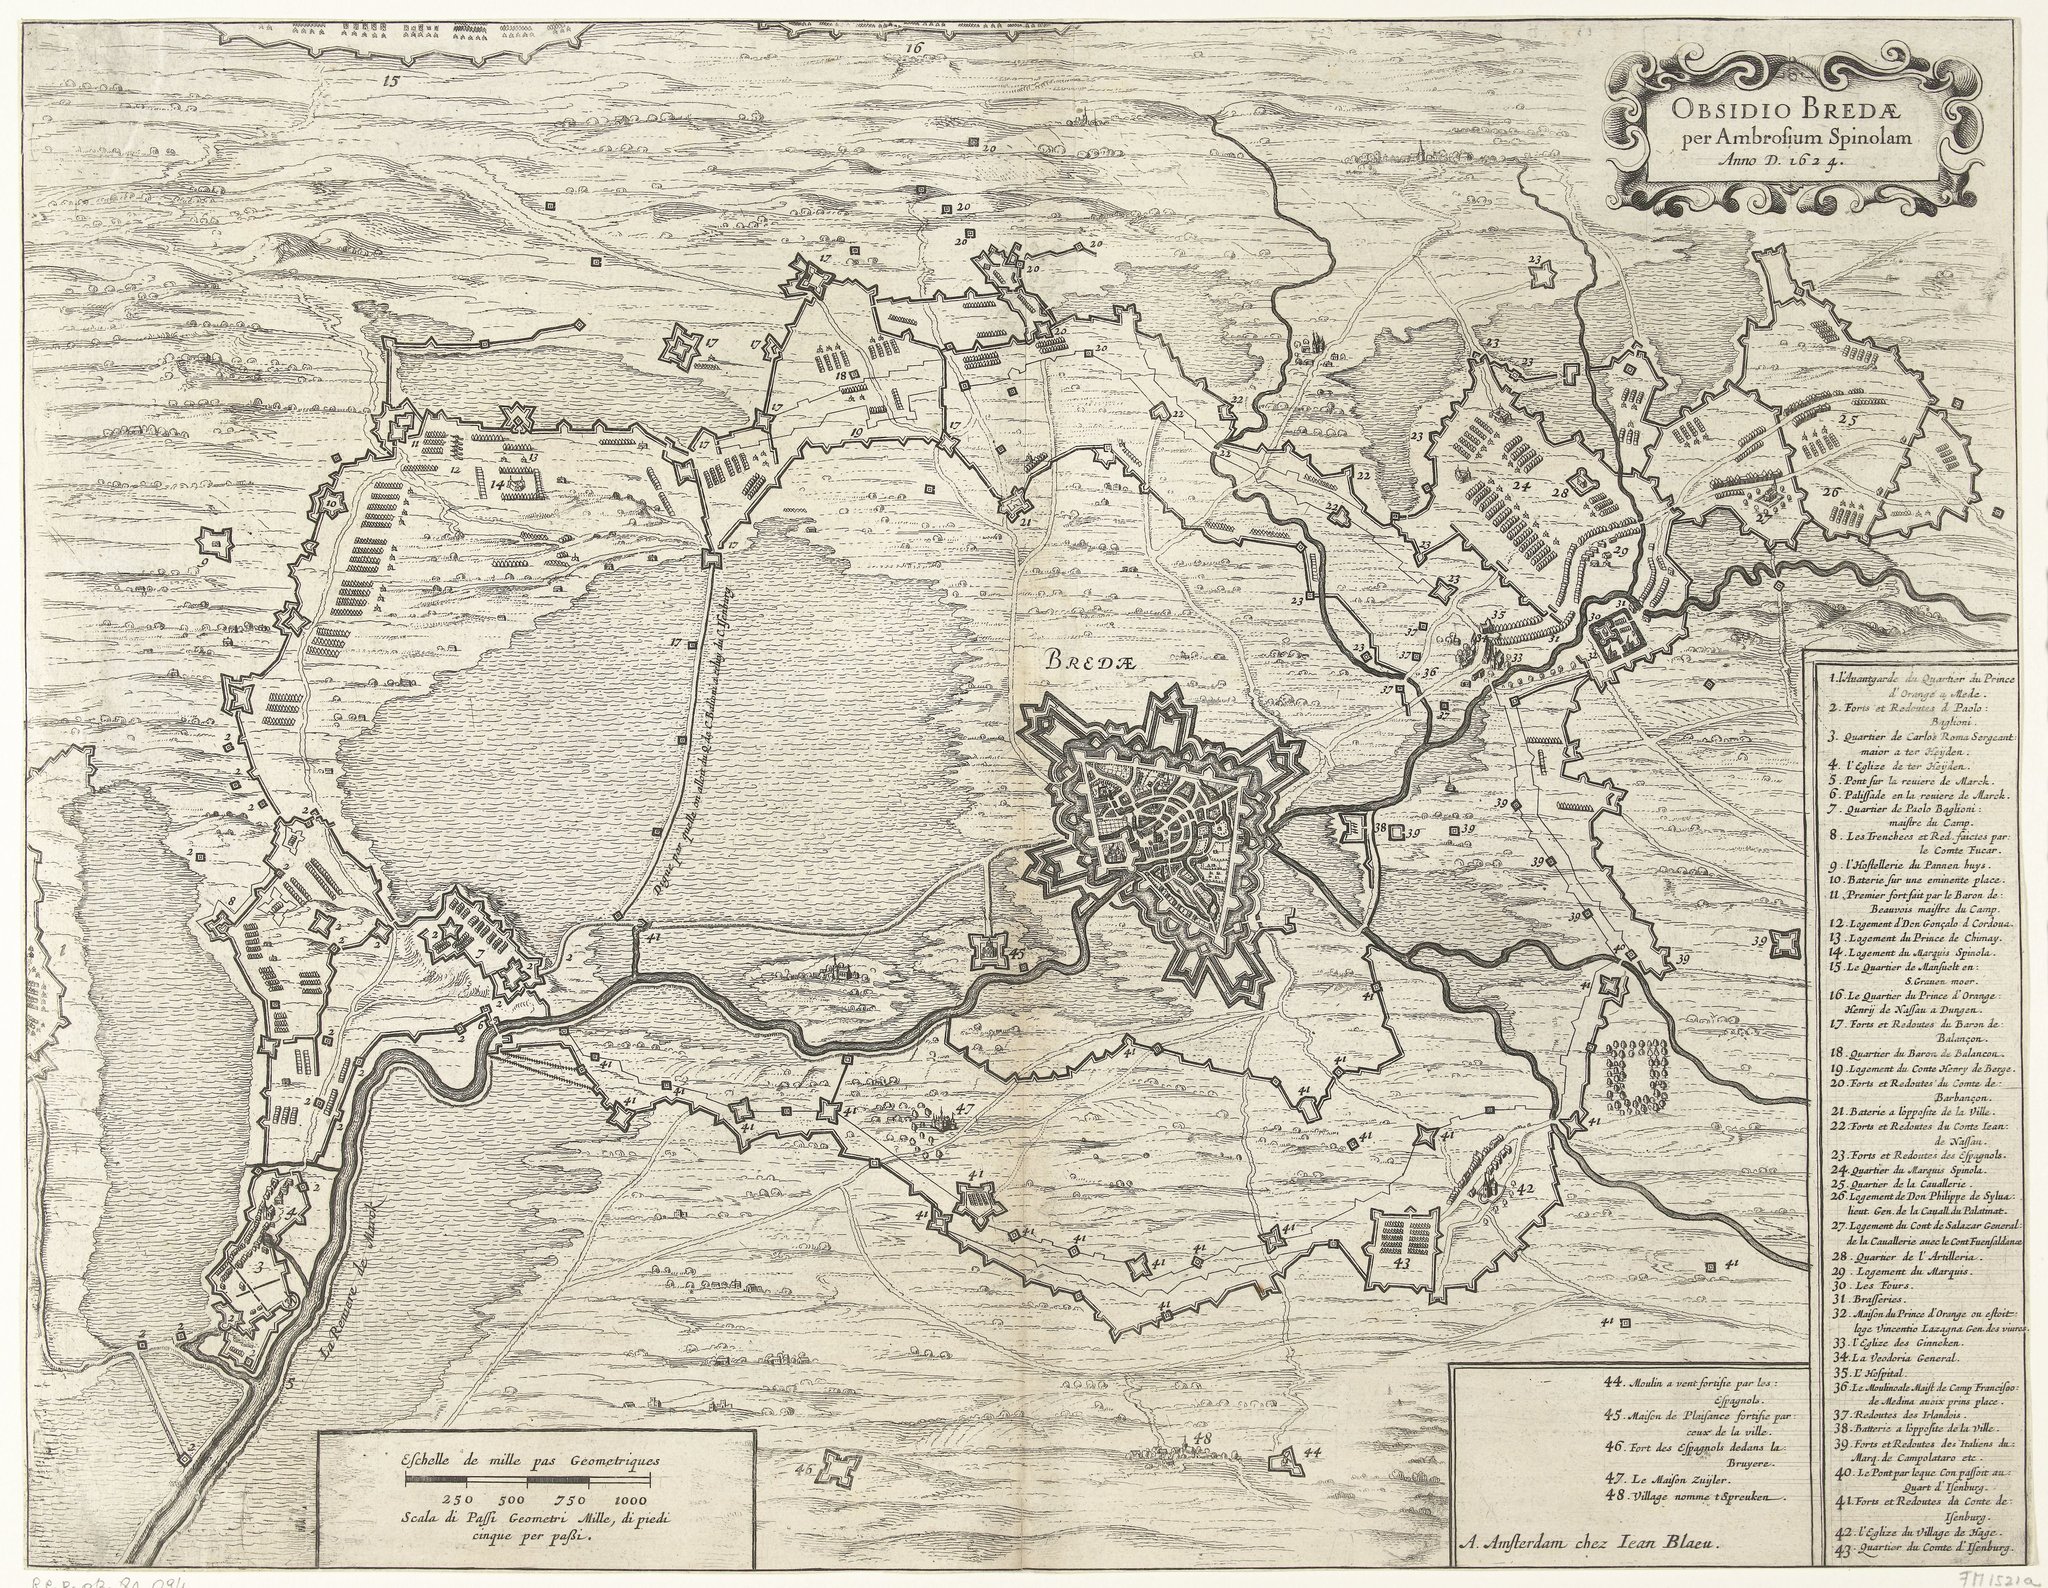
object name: print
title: Obsidio Bredae per Ambrosium Spinolam Anno D. 1624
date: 1647-1649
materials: paper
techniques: etching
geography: amsterdam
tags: maps of separate countries or regions, siege, position war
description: Kaart van het beleg van Breda door het Spaanse leger onder Spinola, 27 augustus 1624 tot 5 juni 1625. Met de omsingeling van de stad en alle forten van de belegerende troepen en de legerplaatsen. Met verschillende cartouches, rechts de legenda 1-48 in het Frans. Op een dubbelblad genomen uit het Stedenboek van Blaeu, bedrukt op verso met tekst in het Latijn.